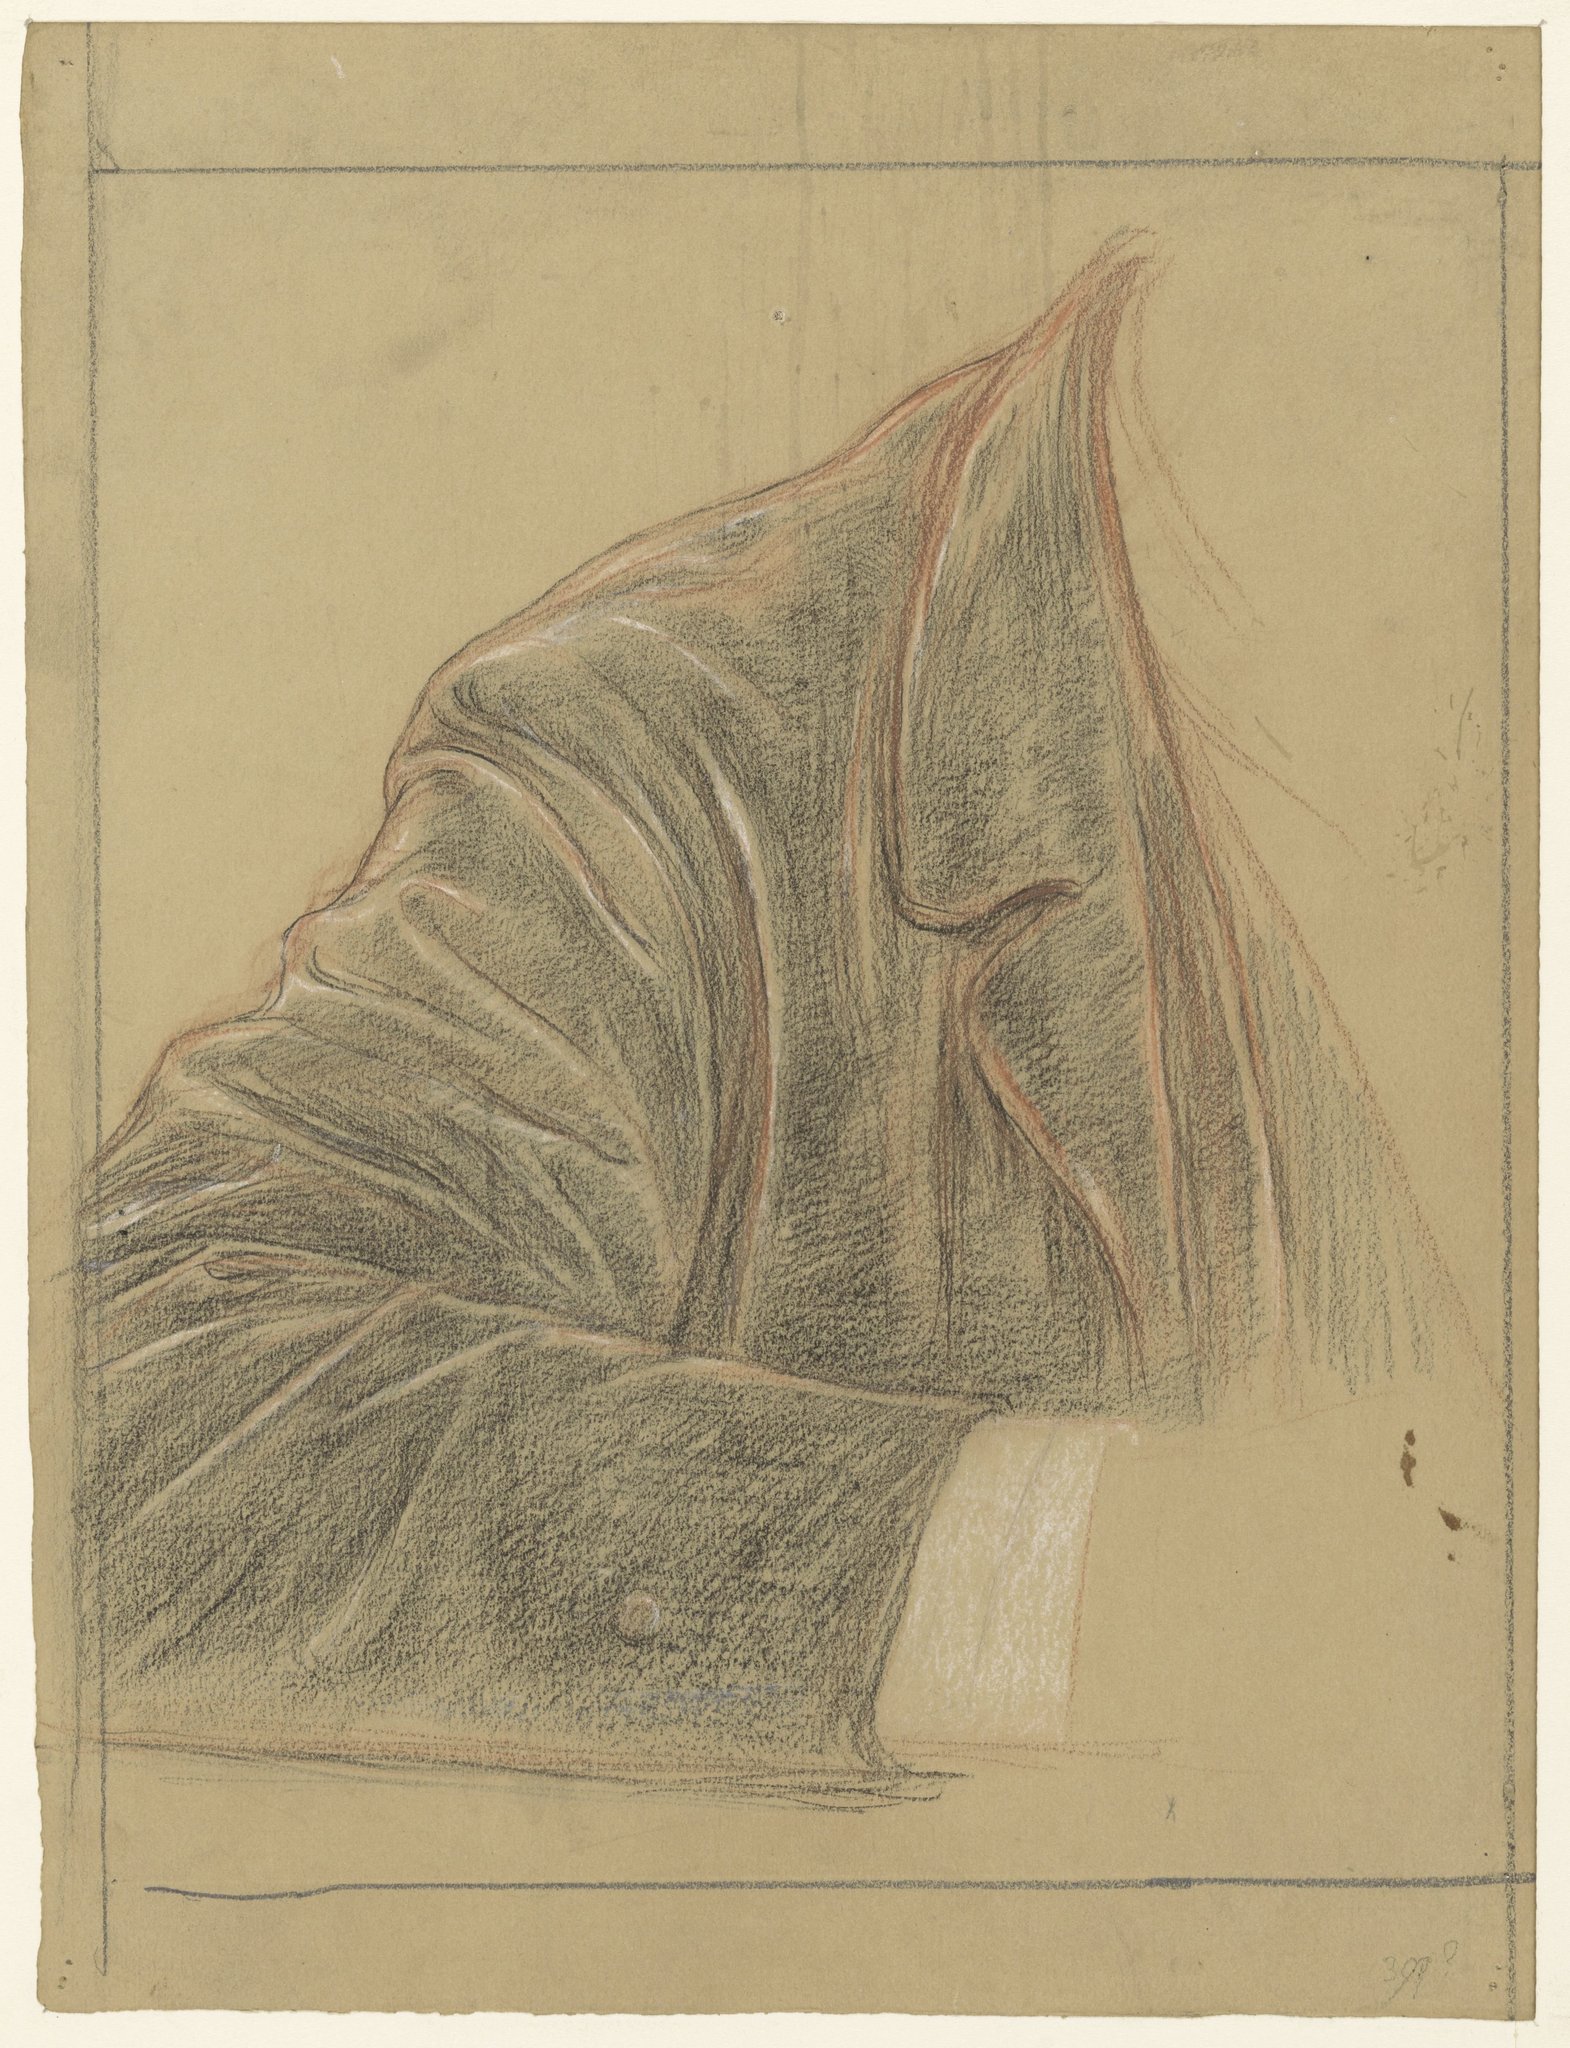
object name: drawing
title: Studie van de jas en arm van Geheimrat M. Kempner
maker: jan veth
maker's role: designer, draughtsman, painter, print maker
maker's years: 1864-1925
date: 1874-1925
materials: chalk, paper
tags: historical persons, drapery, draped garment, 'gewandgebung'